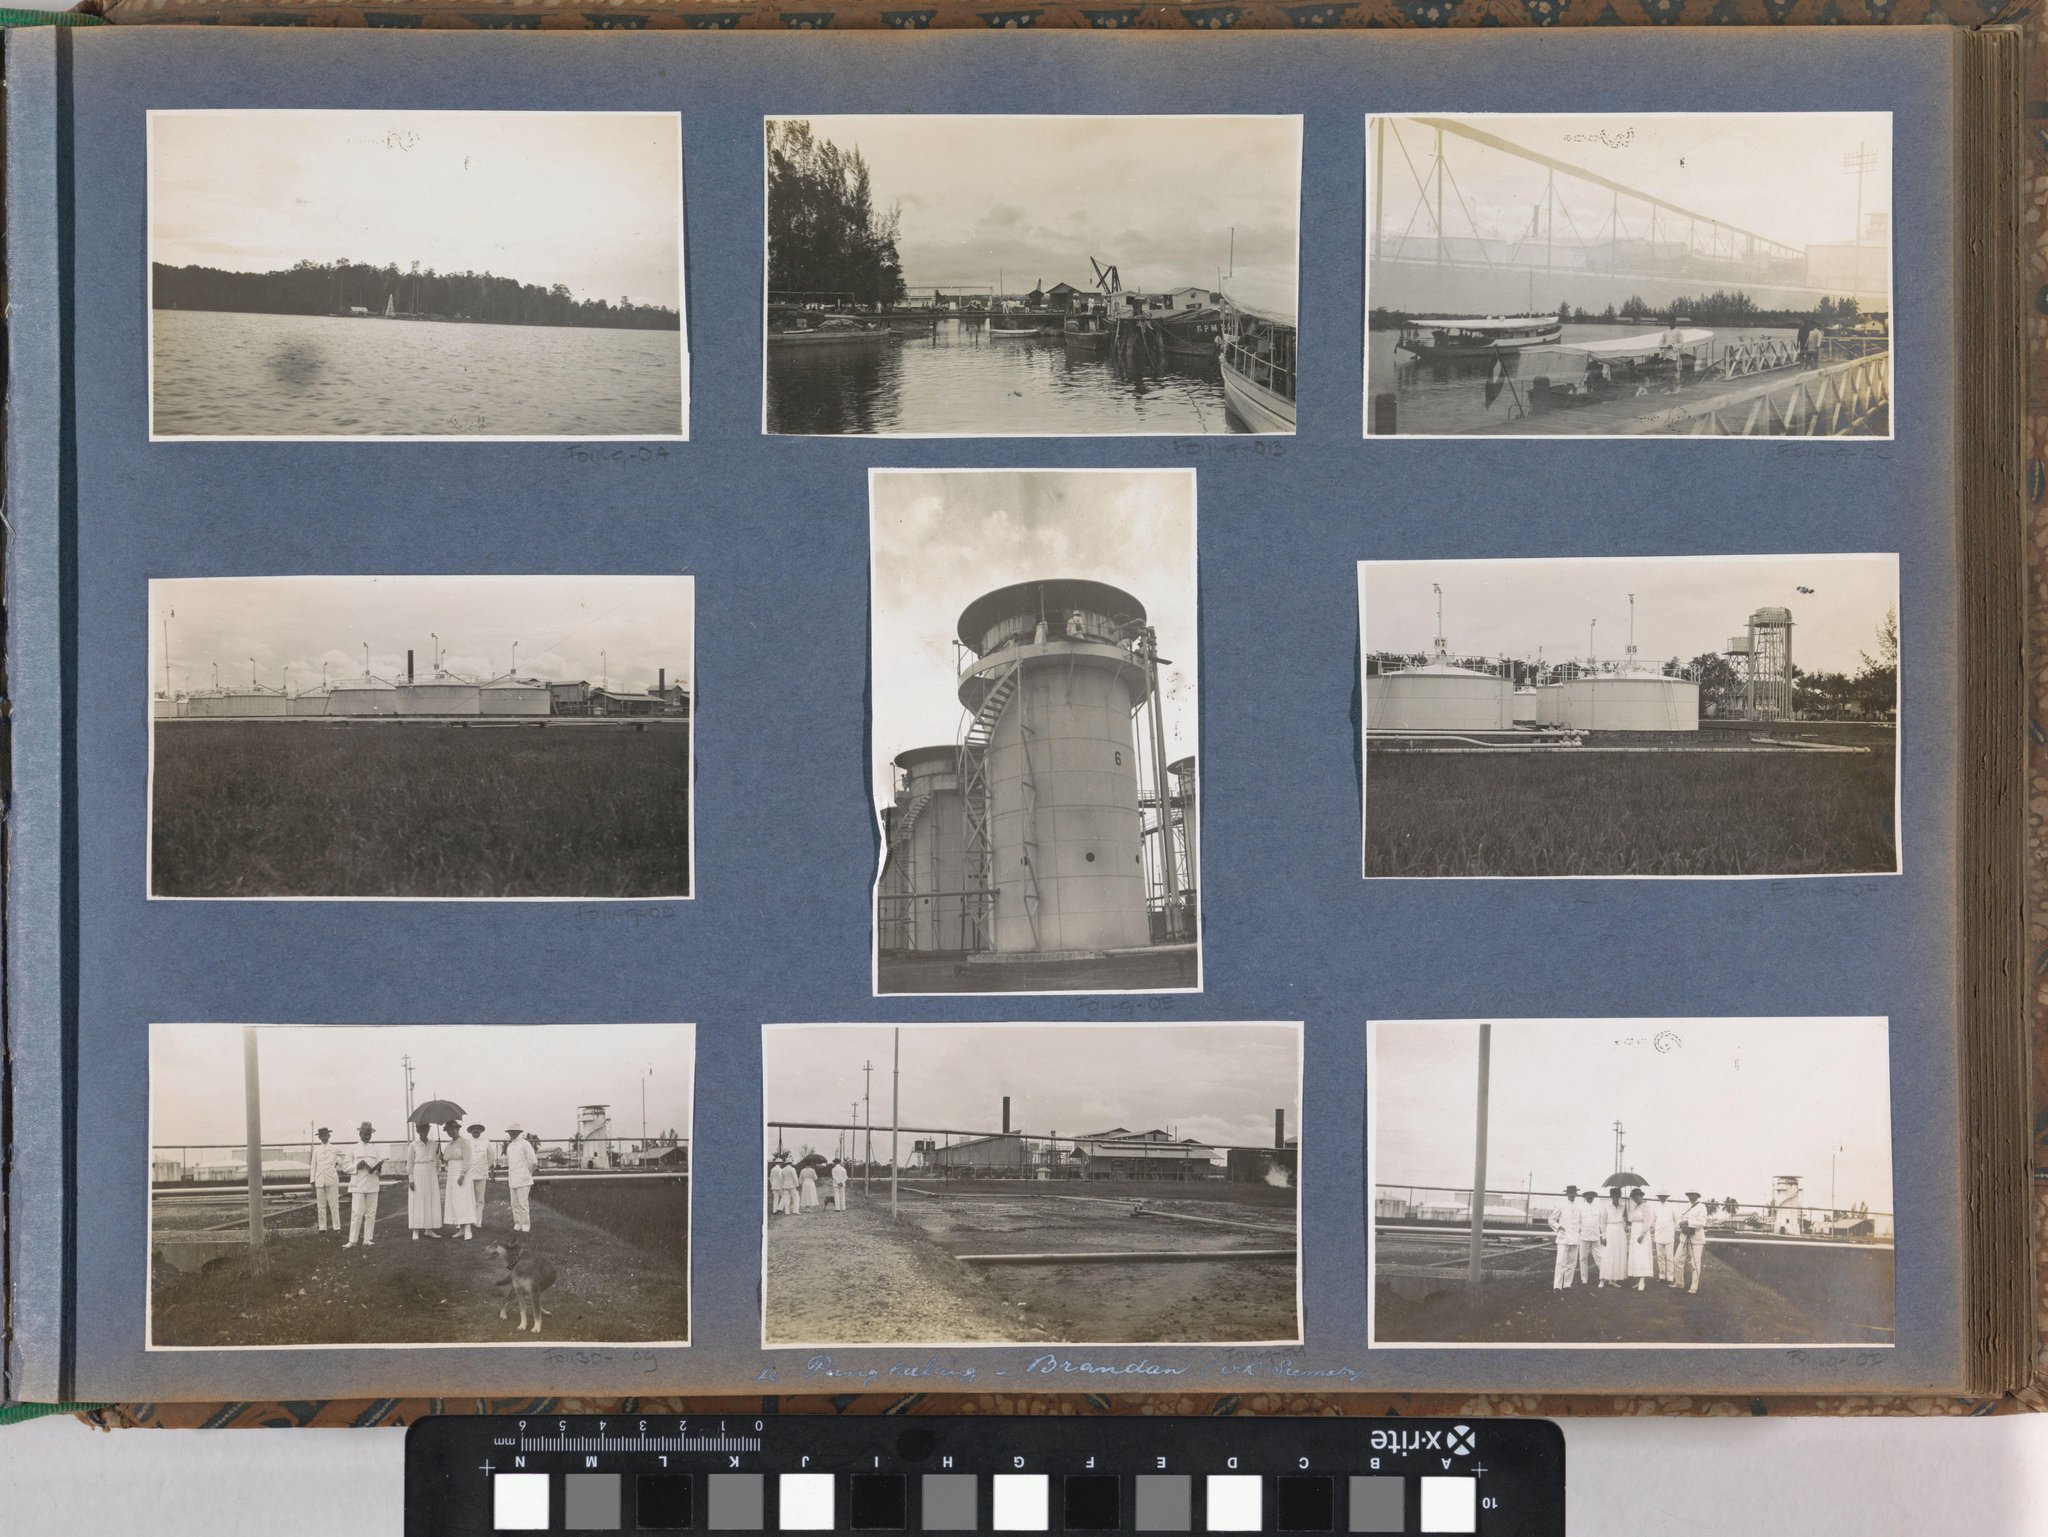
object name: photograph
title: Water te Pangkalan-Brandan op Sumatra met op de oever een olieboortoren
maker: Anonymous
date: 1900-1920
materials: paper, photographic support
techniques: gelatin silver print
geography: sumatra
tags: derrick ~ oil, oil; oil refinery, sumatra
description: Onderdeel van reisalbum met foto's van bedrijvigheid en bezienswaardigheden op Sumatra en Java en van de reis naar en van Nederlands-Indië.